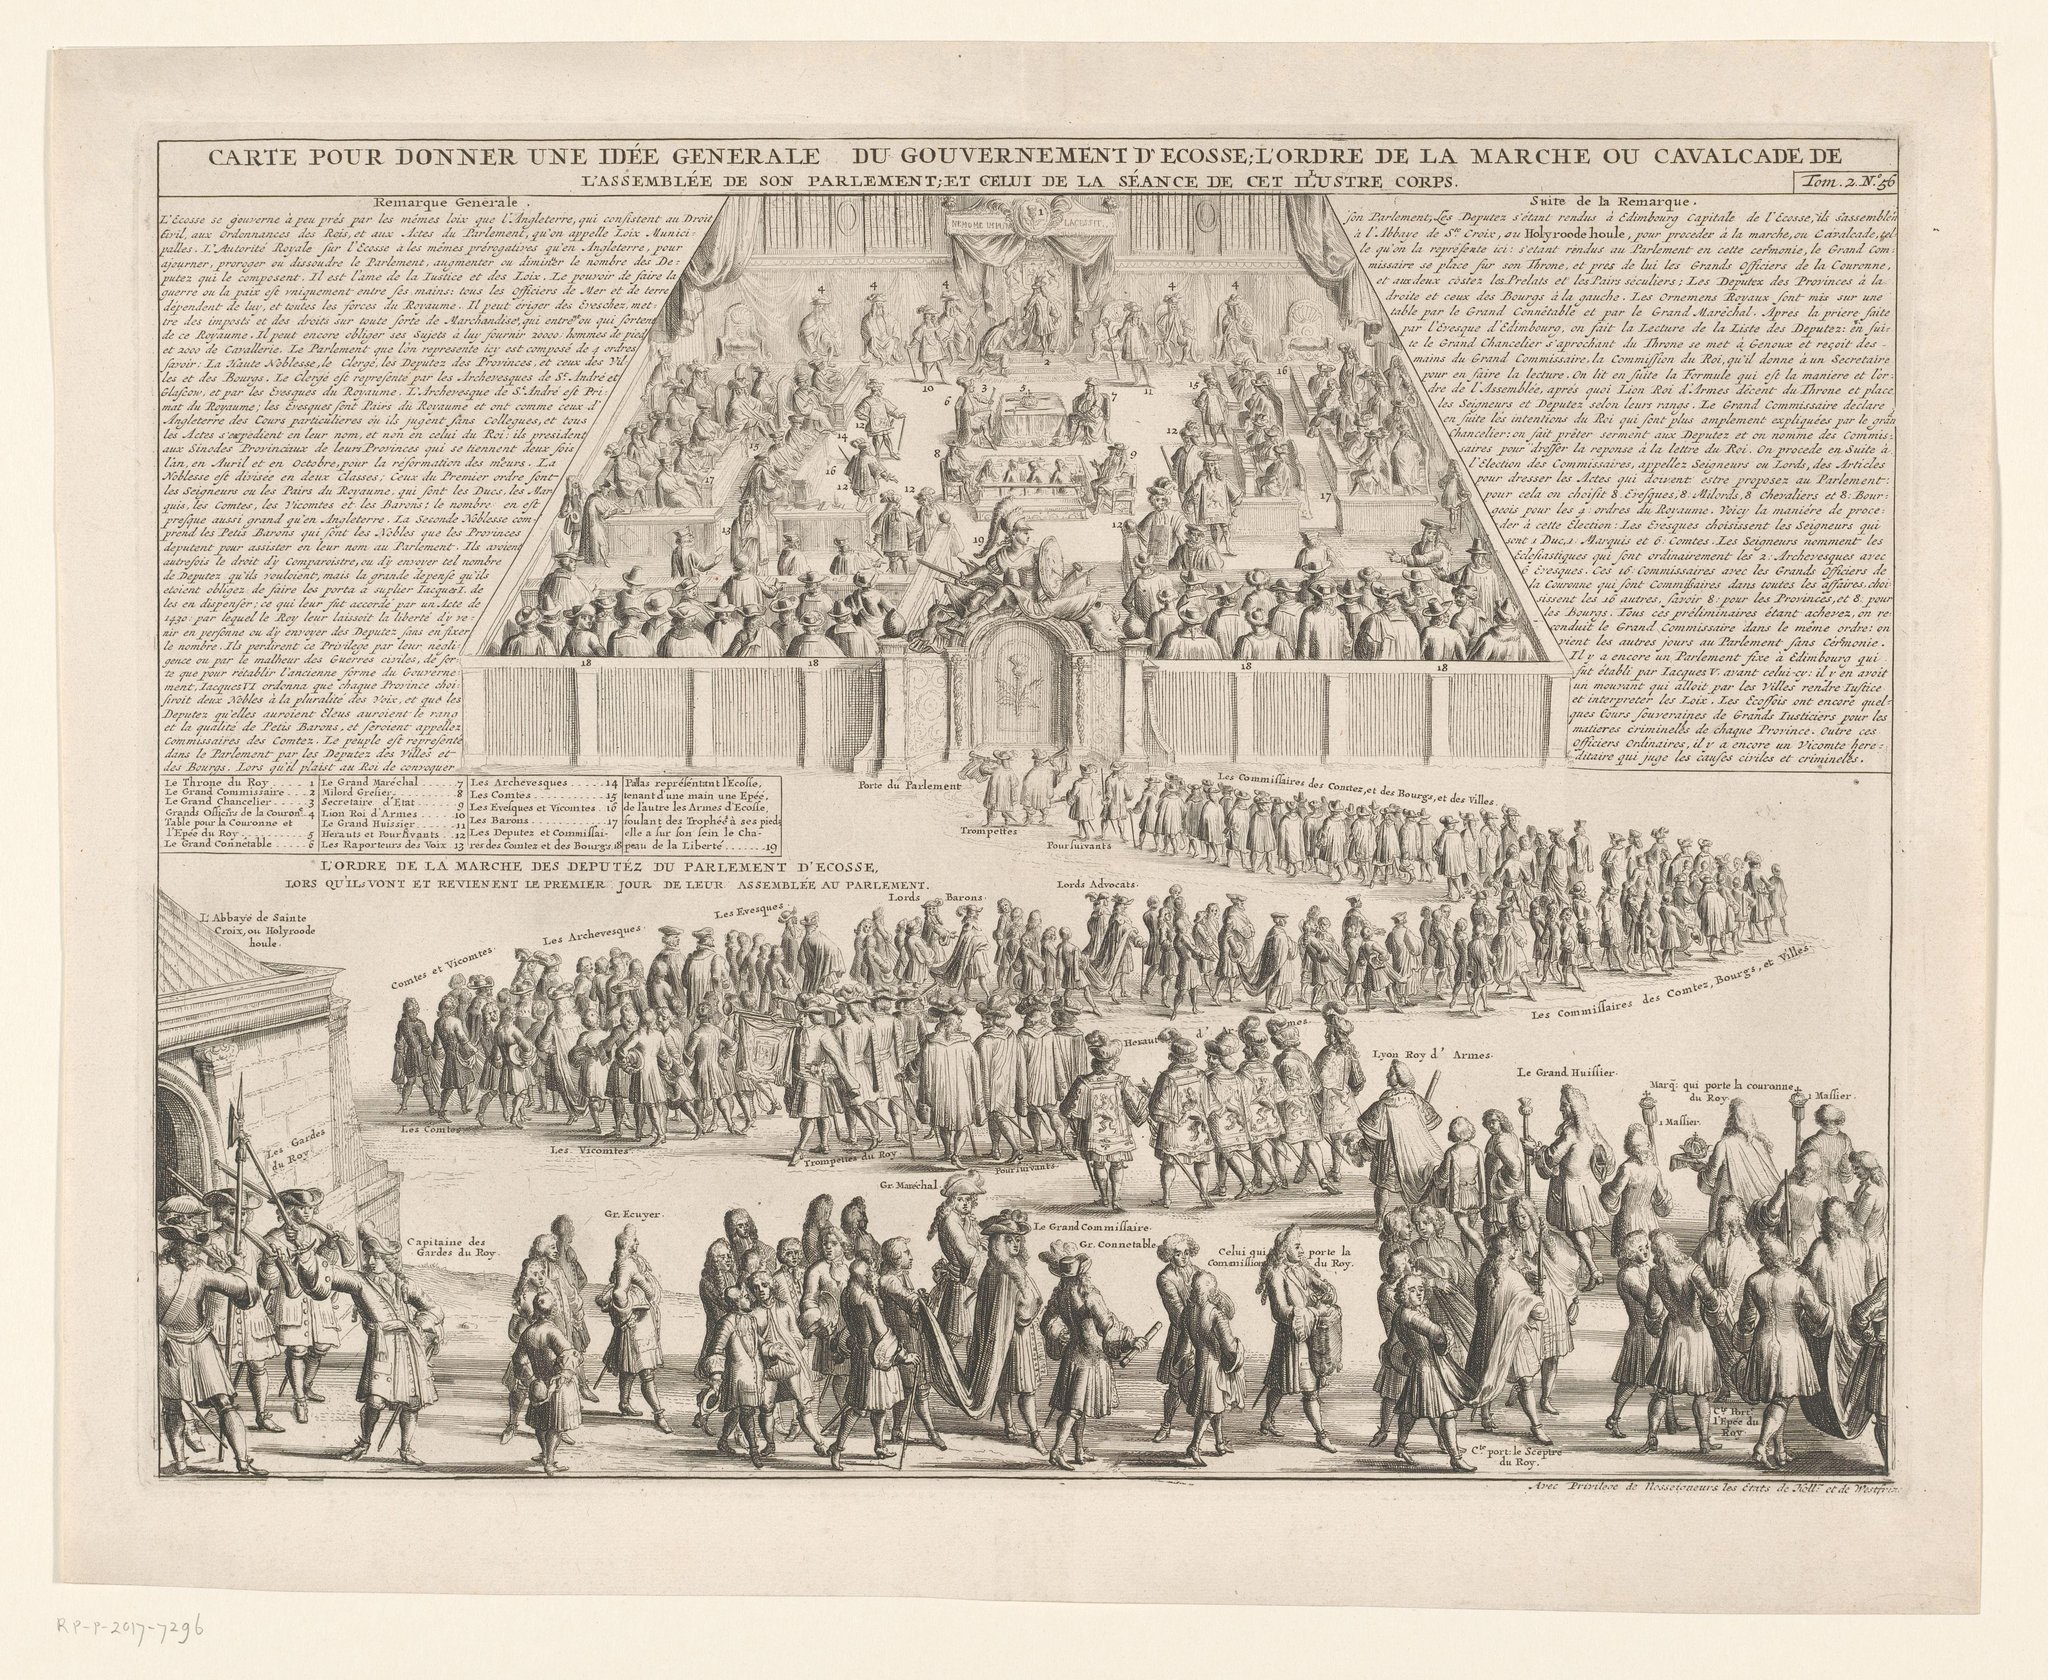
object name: print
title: Het Schotse parlement, 1708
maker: Anonymous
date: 1706-1708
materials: paper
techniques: engraving, etching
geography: low countries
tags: lower house, parliament, chamber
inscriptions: collector's mark: Lugt 2228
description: Gebruikt als illustratie in: Henri Abraham Chatelain, Atlas historique, ou Nouvelle introduction à l'histoire, à la chronologie & à la géographie ancienne & moderne, vol. II, dl. 2, Amsterdam: Freres Chatelain, 1708.